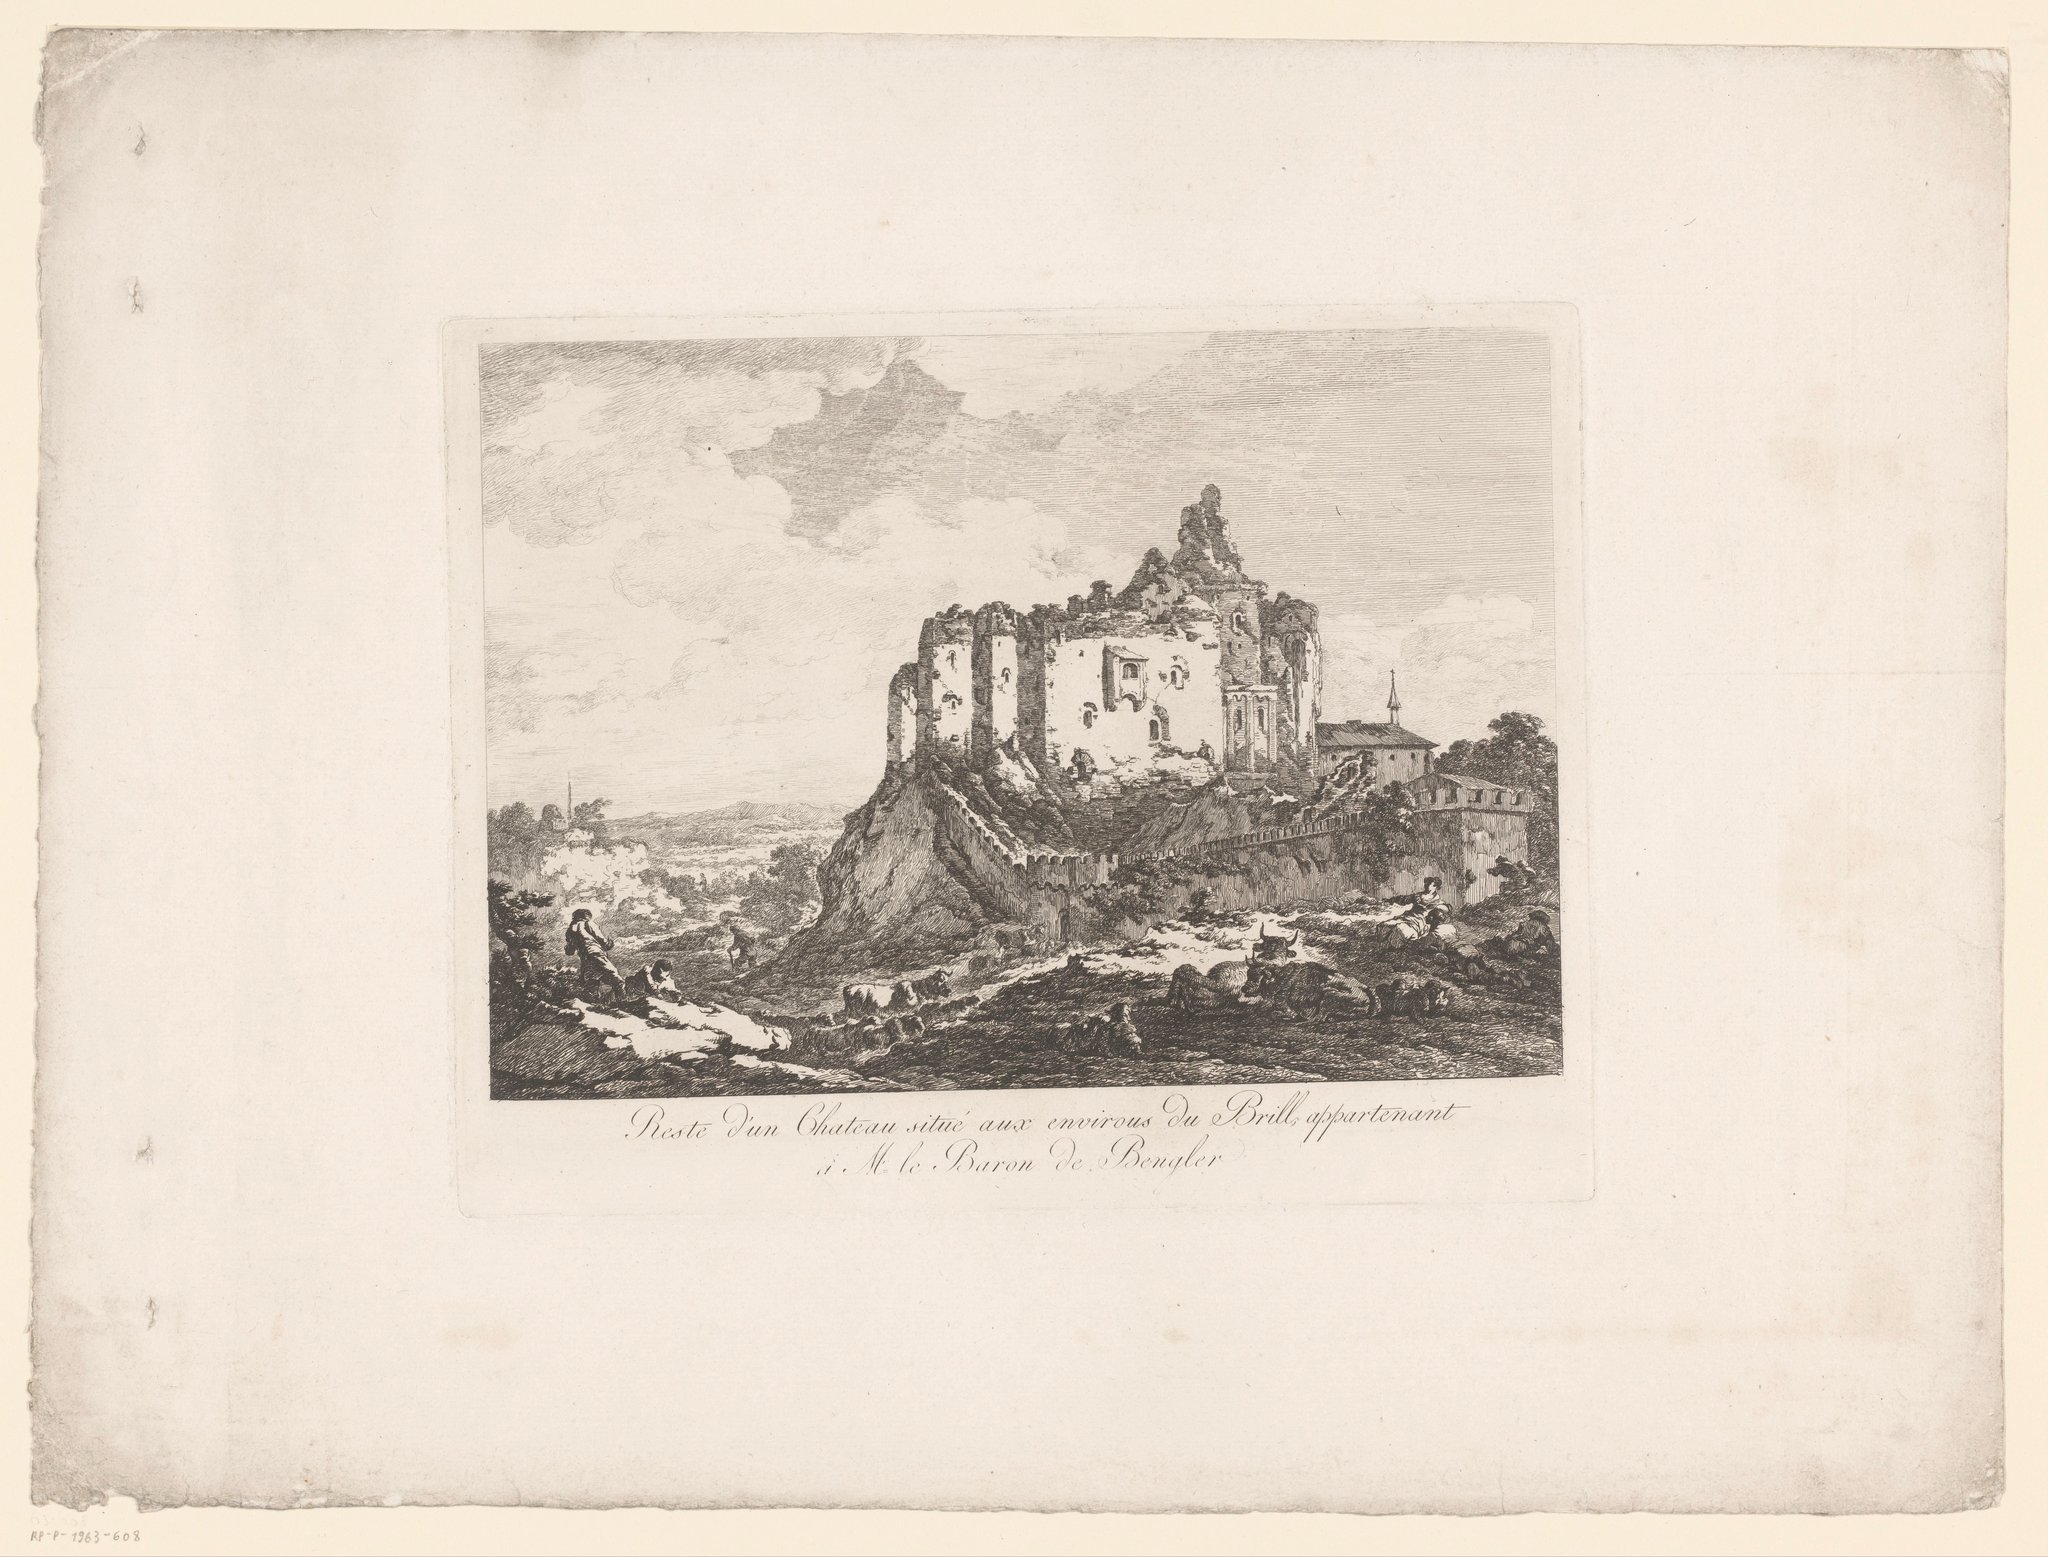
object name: print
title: Differens Sujets graves et dessinés par Ignace du Vivier: d'apres ses tableaux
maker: Anonymous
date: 1793-1832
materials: paper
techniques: drypoint, etching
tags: castle, landscape with ruins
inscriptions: collector's mark: Lugt 2228, collector's mark: Lugt 2760